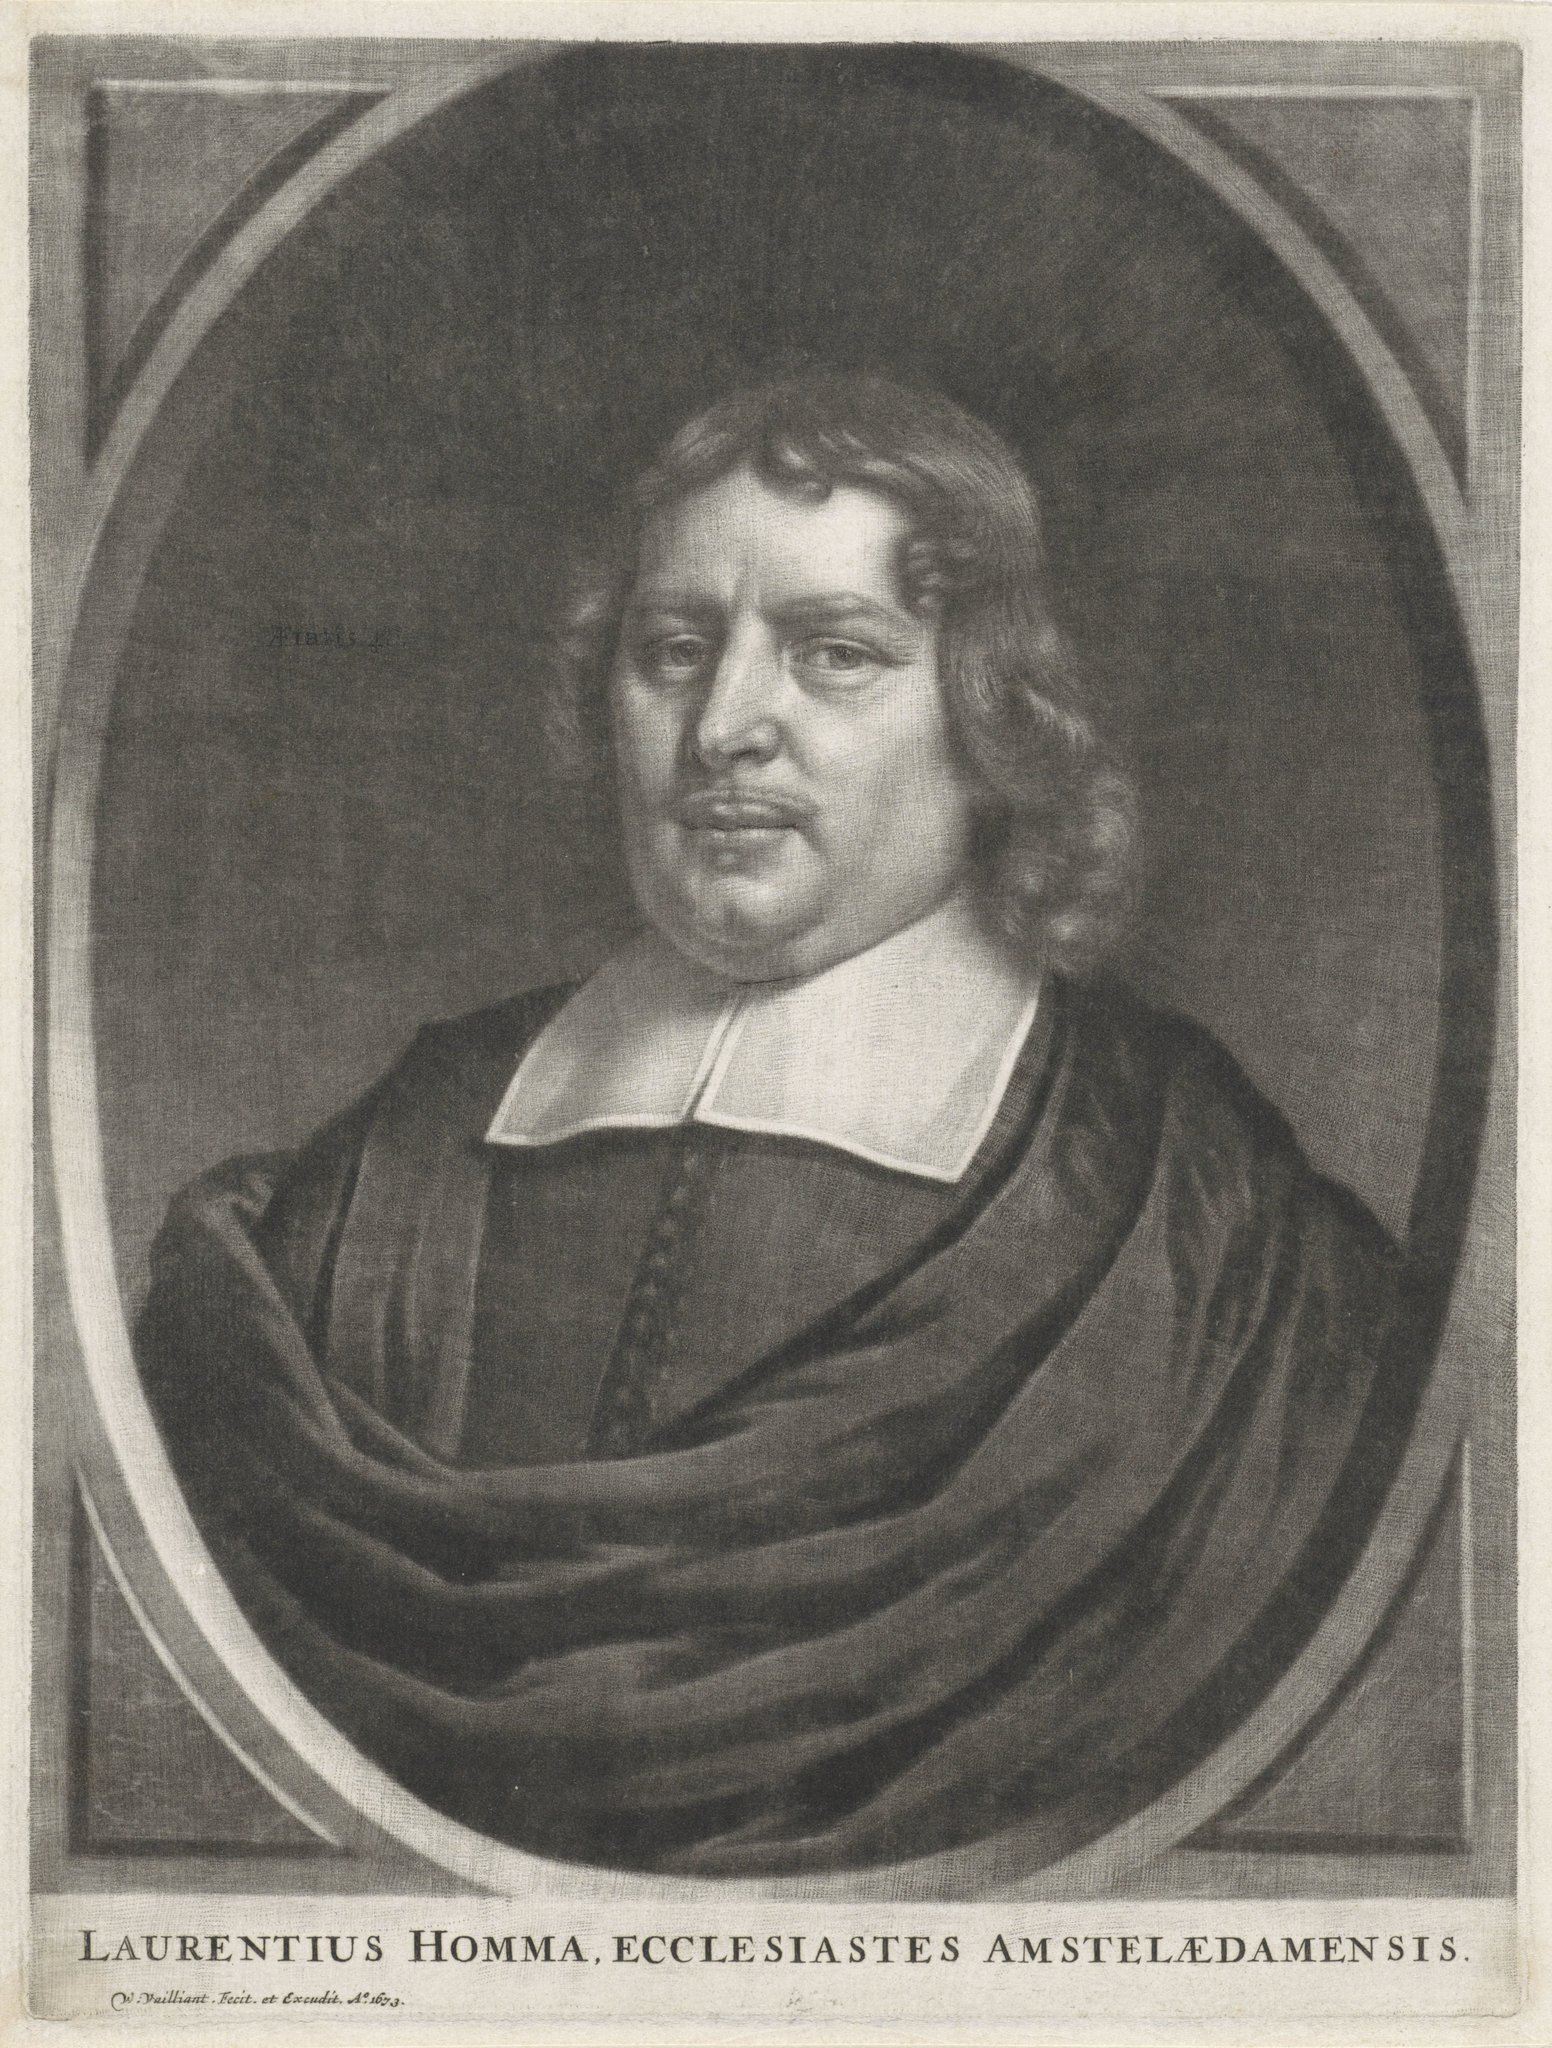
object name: print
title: Portret van de predikant Laurentius Homma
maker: wallerant vaillant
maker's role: draughtsman, painter, print maker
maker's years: 1623-1677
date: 1673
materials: paper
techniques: mezzotint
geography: amsterdam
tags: amsterdam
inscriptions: collector's mark: Lugt 2228